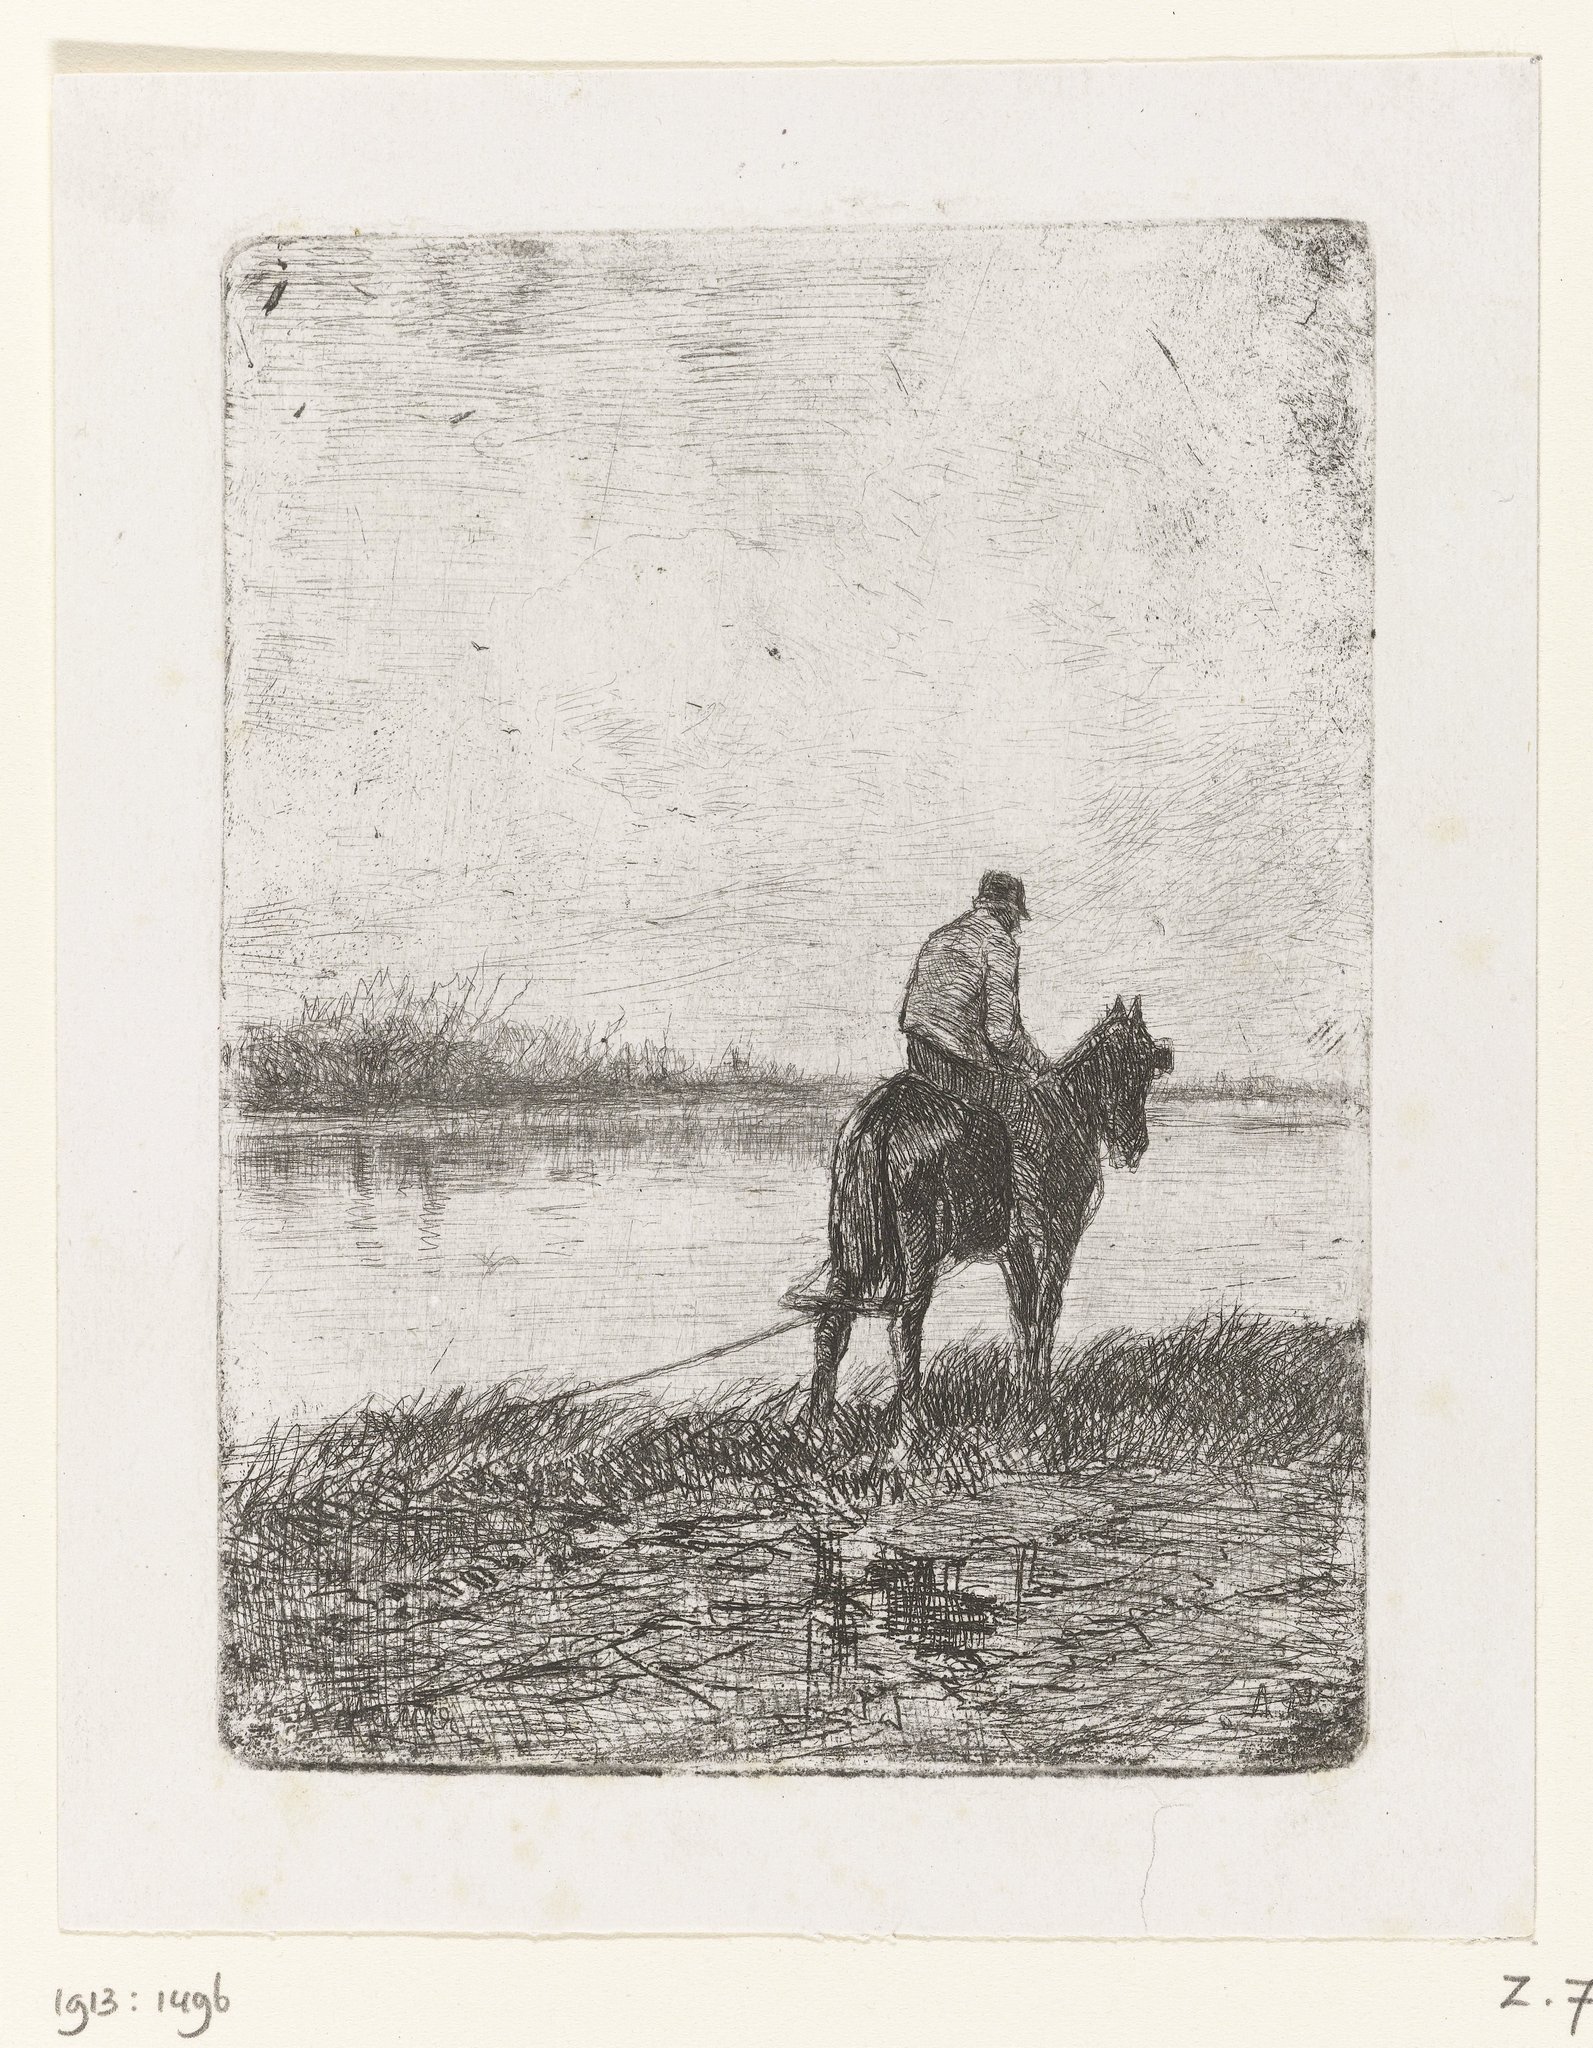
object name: print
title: Jaagpad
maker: anton mauve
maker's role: draughtsman, painter, print maker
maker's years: 1838-1888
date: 1848-1888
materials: paper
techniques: etching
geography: netherlands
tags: horse, towing path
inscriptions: collector's mark: Lugt 2228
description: Op het jaagpad naast een vaart rijdt een ruiter op een paard.